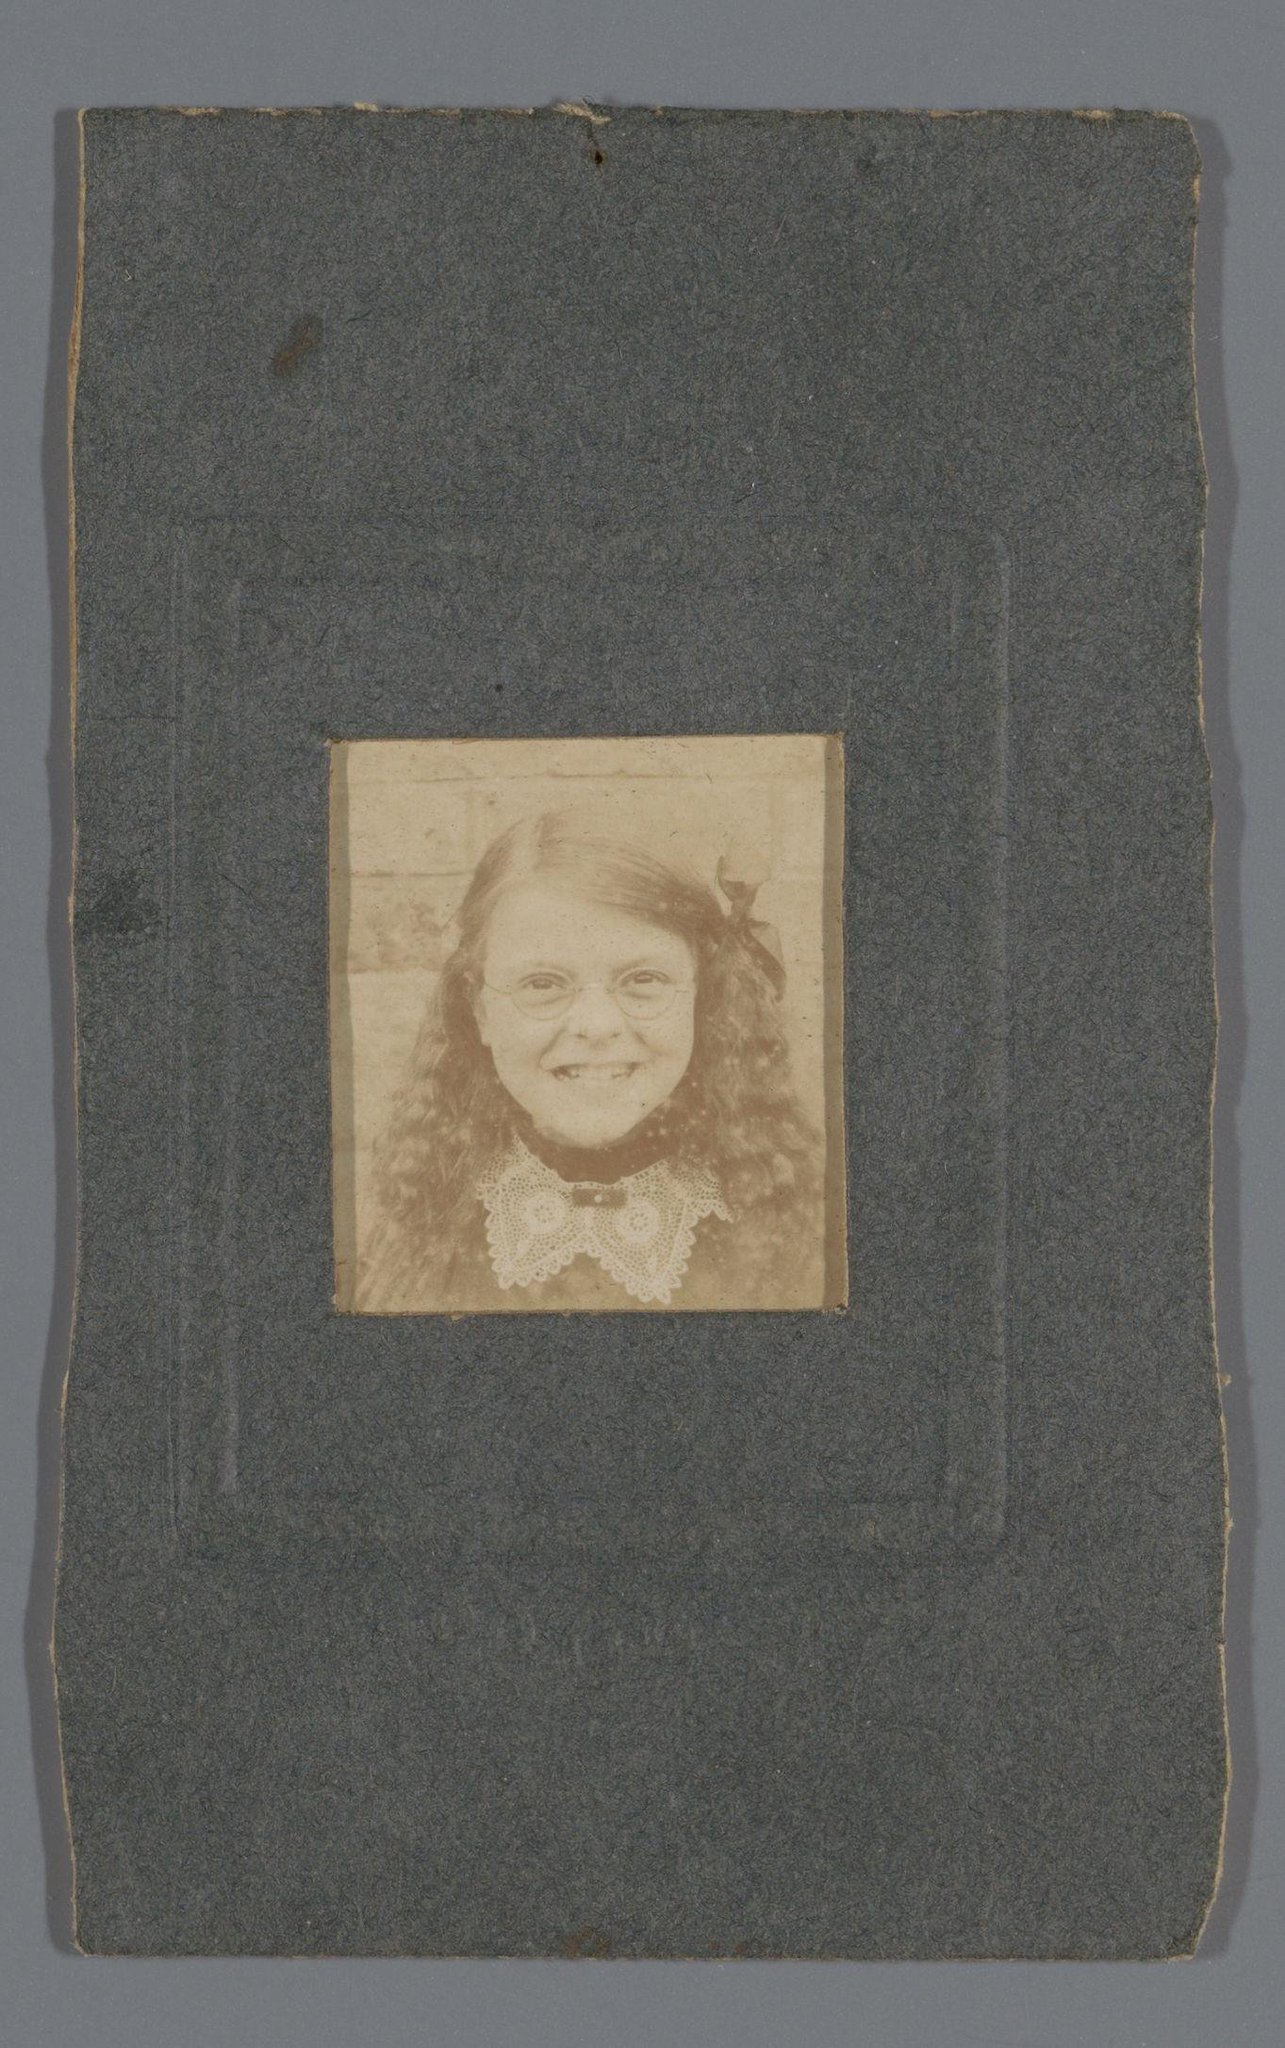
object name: photograph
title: Portret van een onbekend meisje met een bril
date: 1910-1920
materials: cardboard, photographic support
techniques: gelatin silver print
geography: bromley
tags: eyeglasses, spectacles, girl (child between toddler and youth)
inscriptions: inscription: ‘Mayze Bros - 16 - Station Road Bromley Kent’